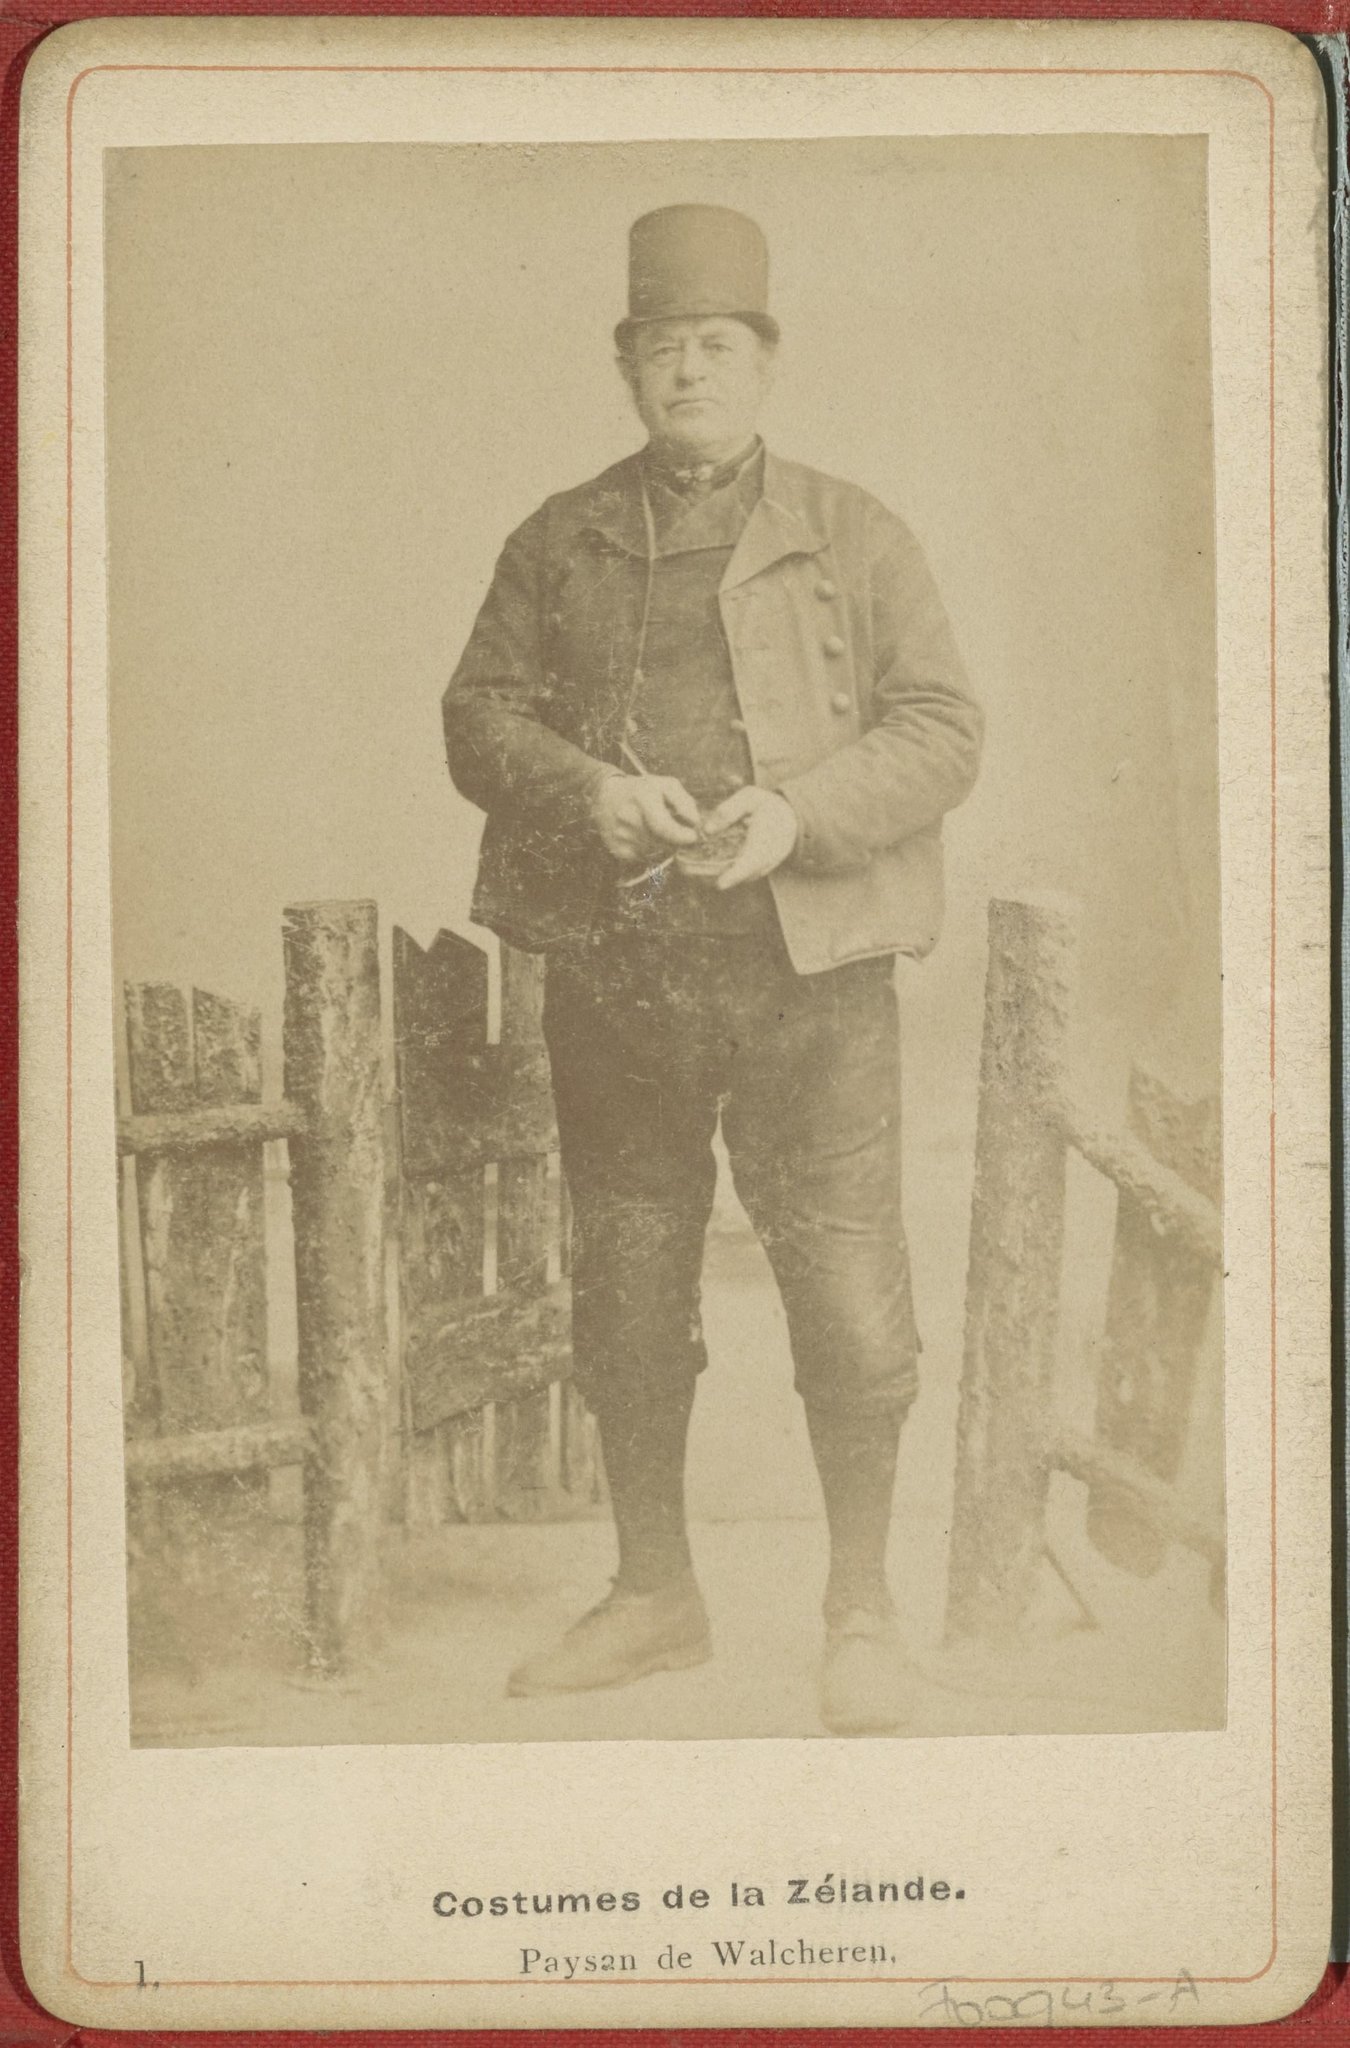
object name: photograph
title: Man in de klederdracht van Walcheren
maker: Anonymous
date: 1870-1910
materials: cardboard, photographic support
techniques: albumen print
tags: folk costume, regional costume (+ men's clothes)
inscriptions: number: ‘1’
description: Onderdeel van Leporelloalbum met Zeeuwse klederdrachten.